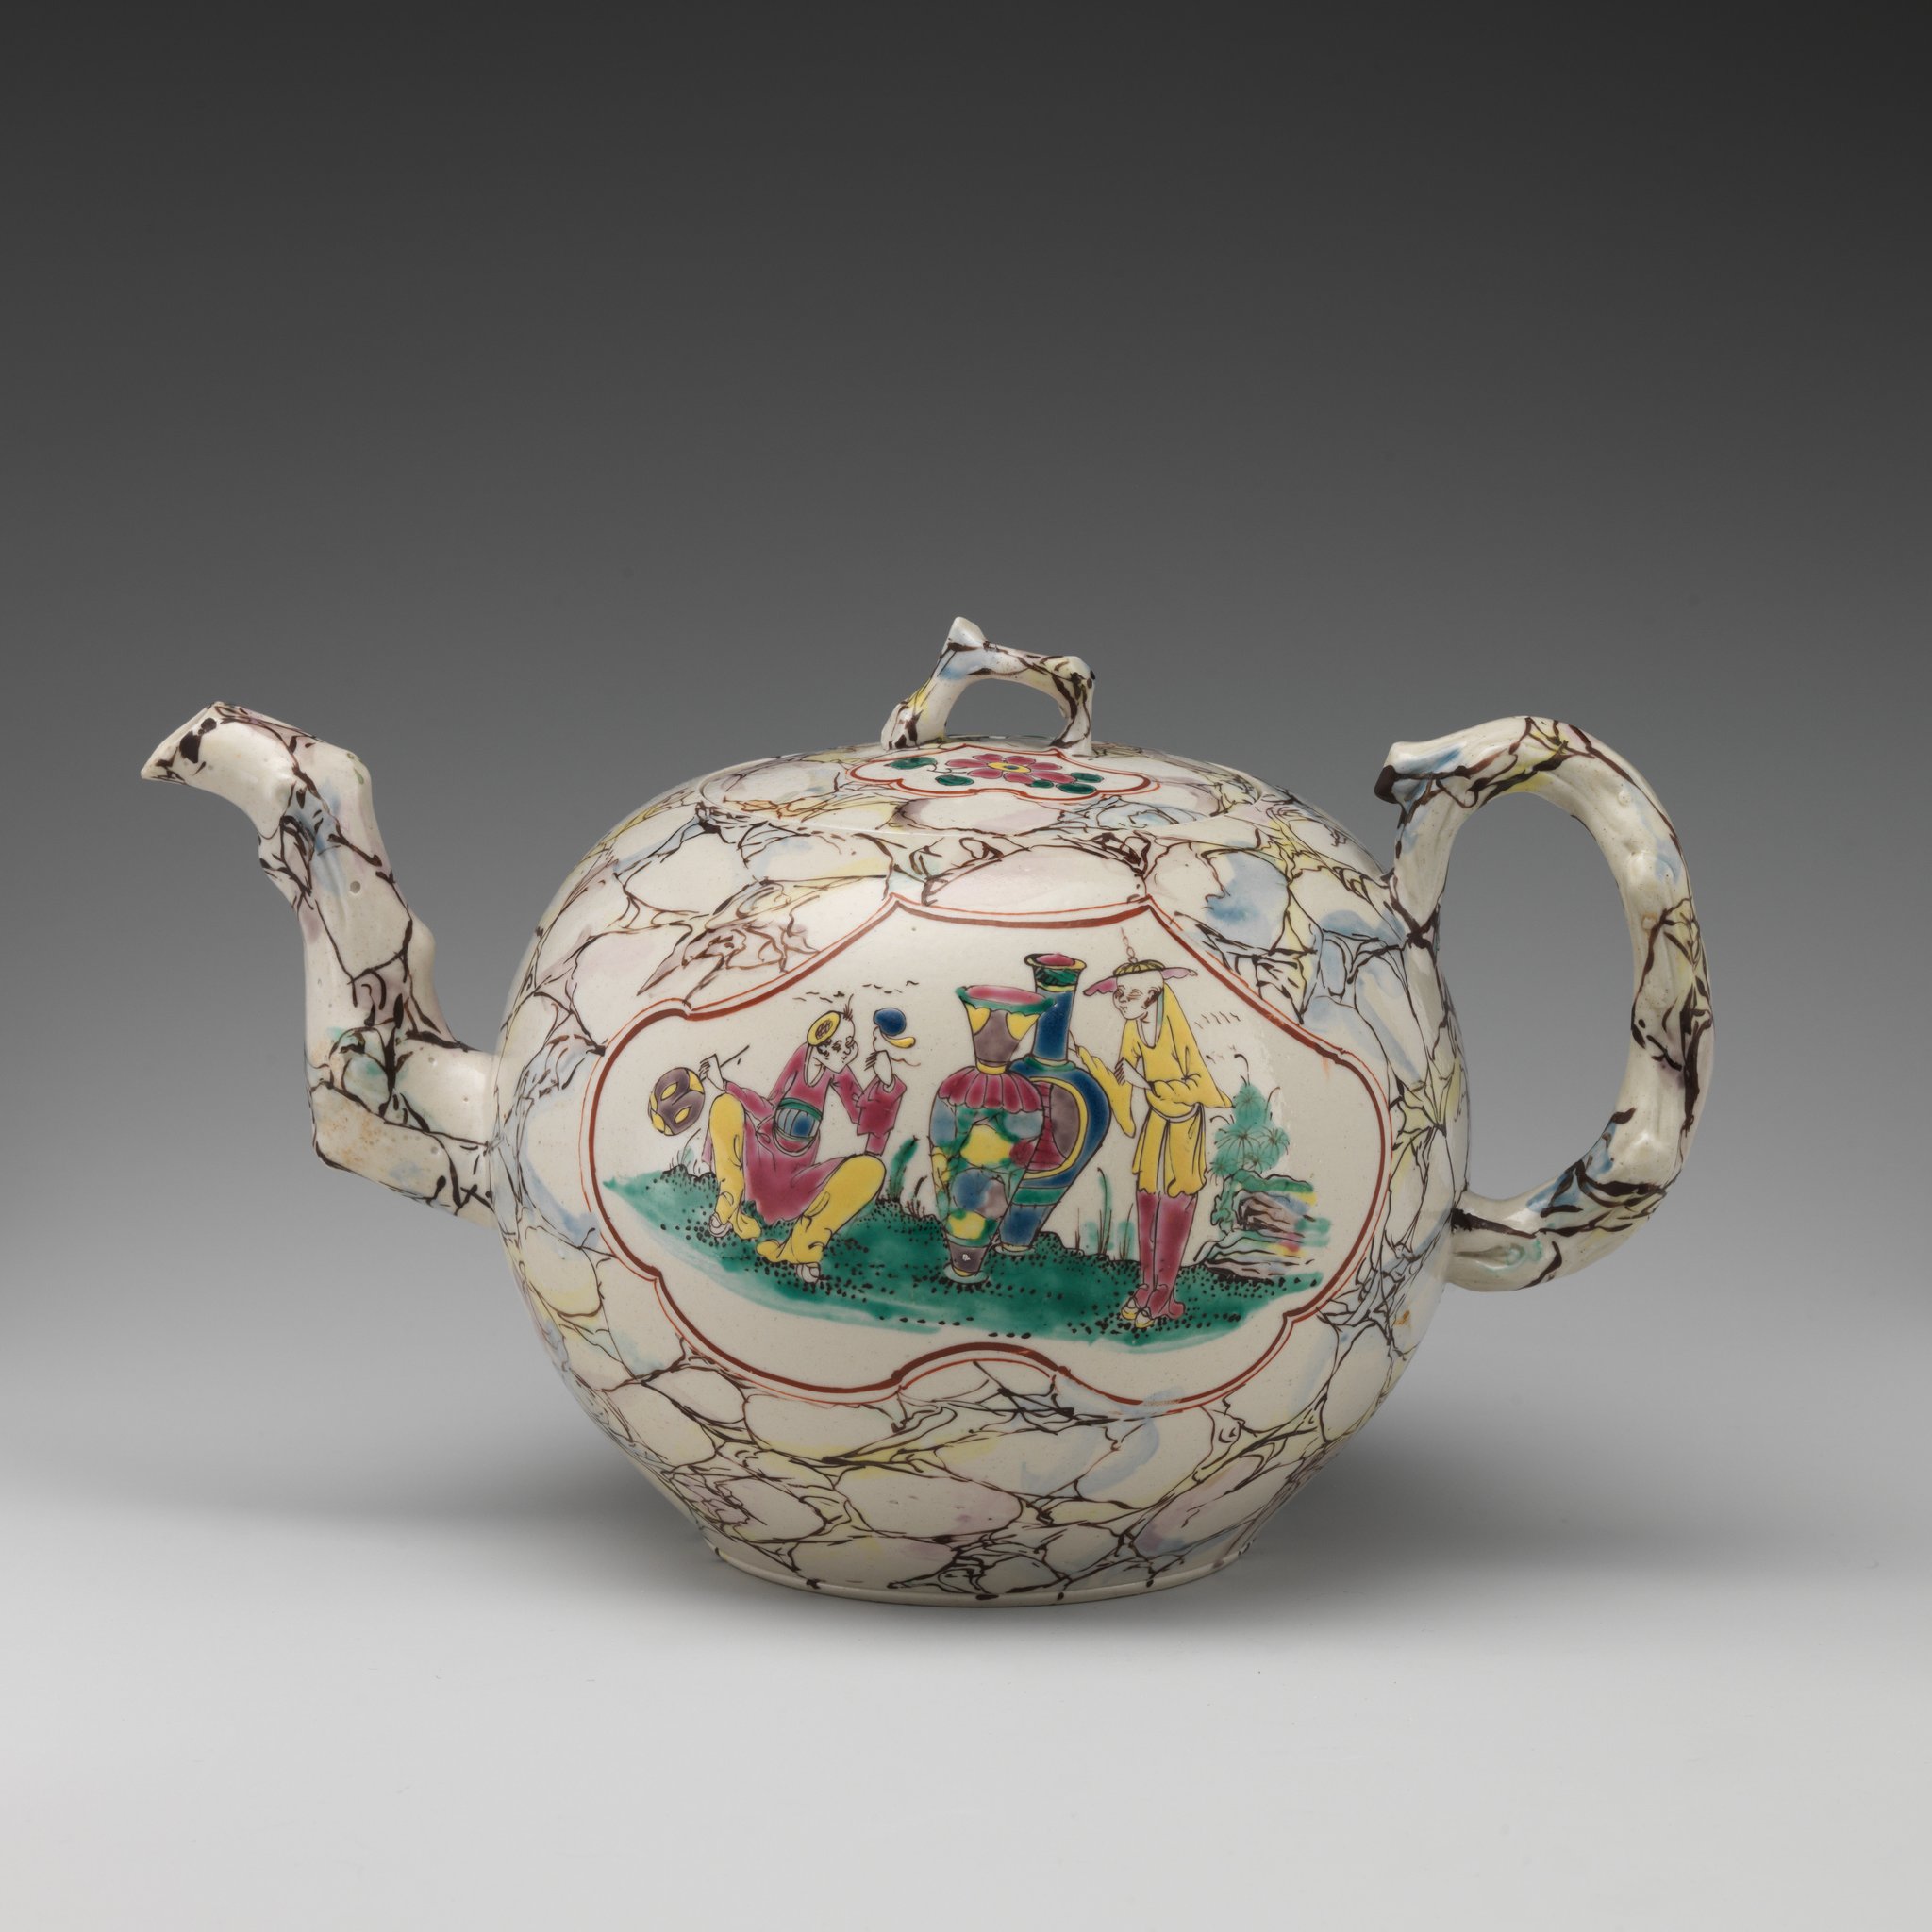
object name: teapot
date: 1760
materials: enamel, stoneware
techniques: salt glaze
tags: human figures